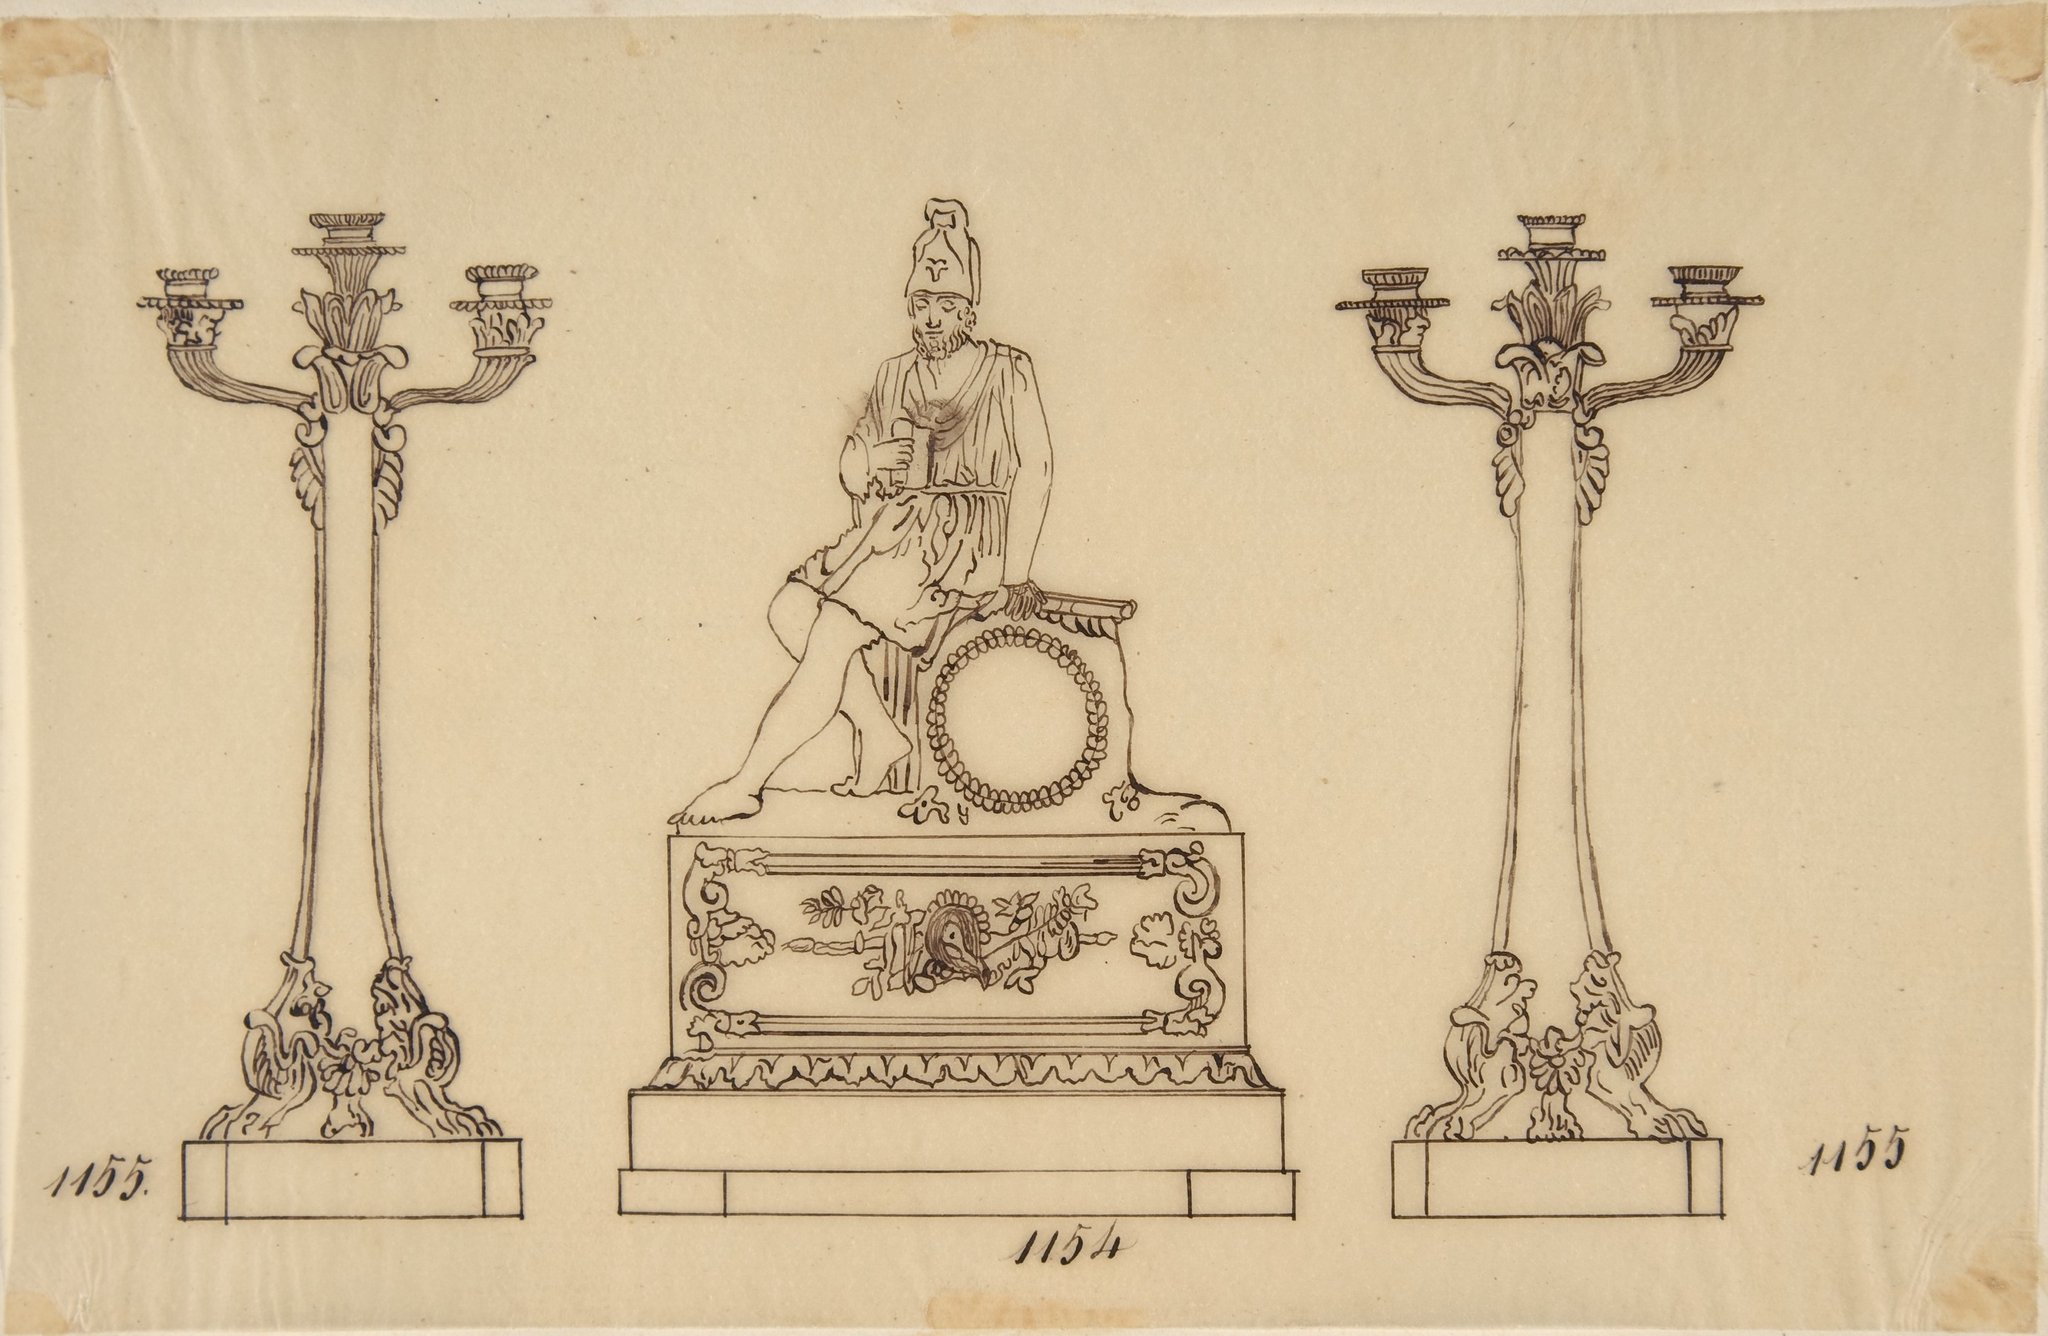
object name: drawing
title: Design for a Set of Candlesticks and a Clock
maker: anonymous, french, 19th century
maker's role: artist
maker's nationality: french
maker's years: 1800-1900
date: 1801-1900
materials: ink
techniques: pen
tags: clocks,candlesticks